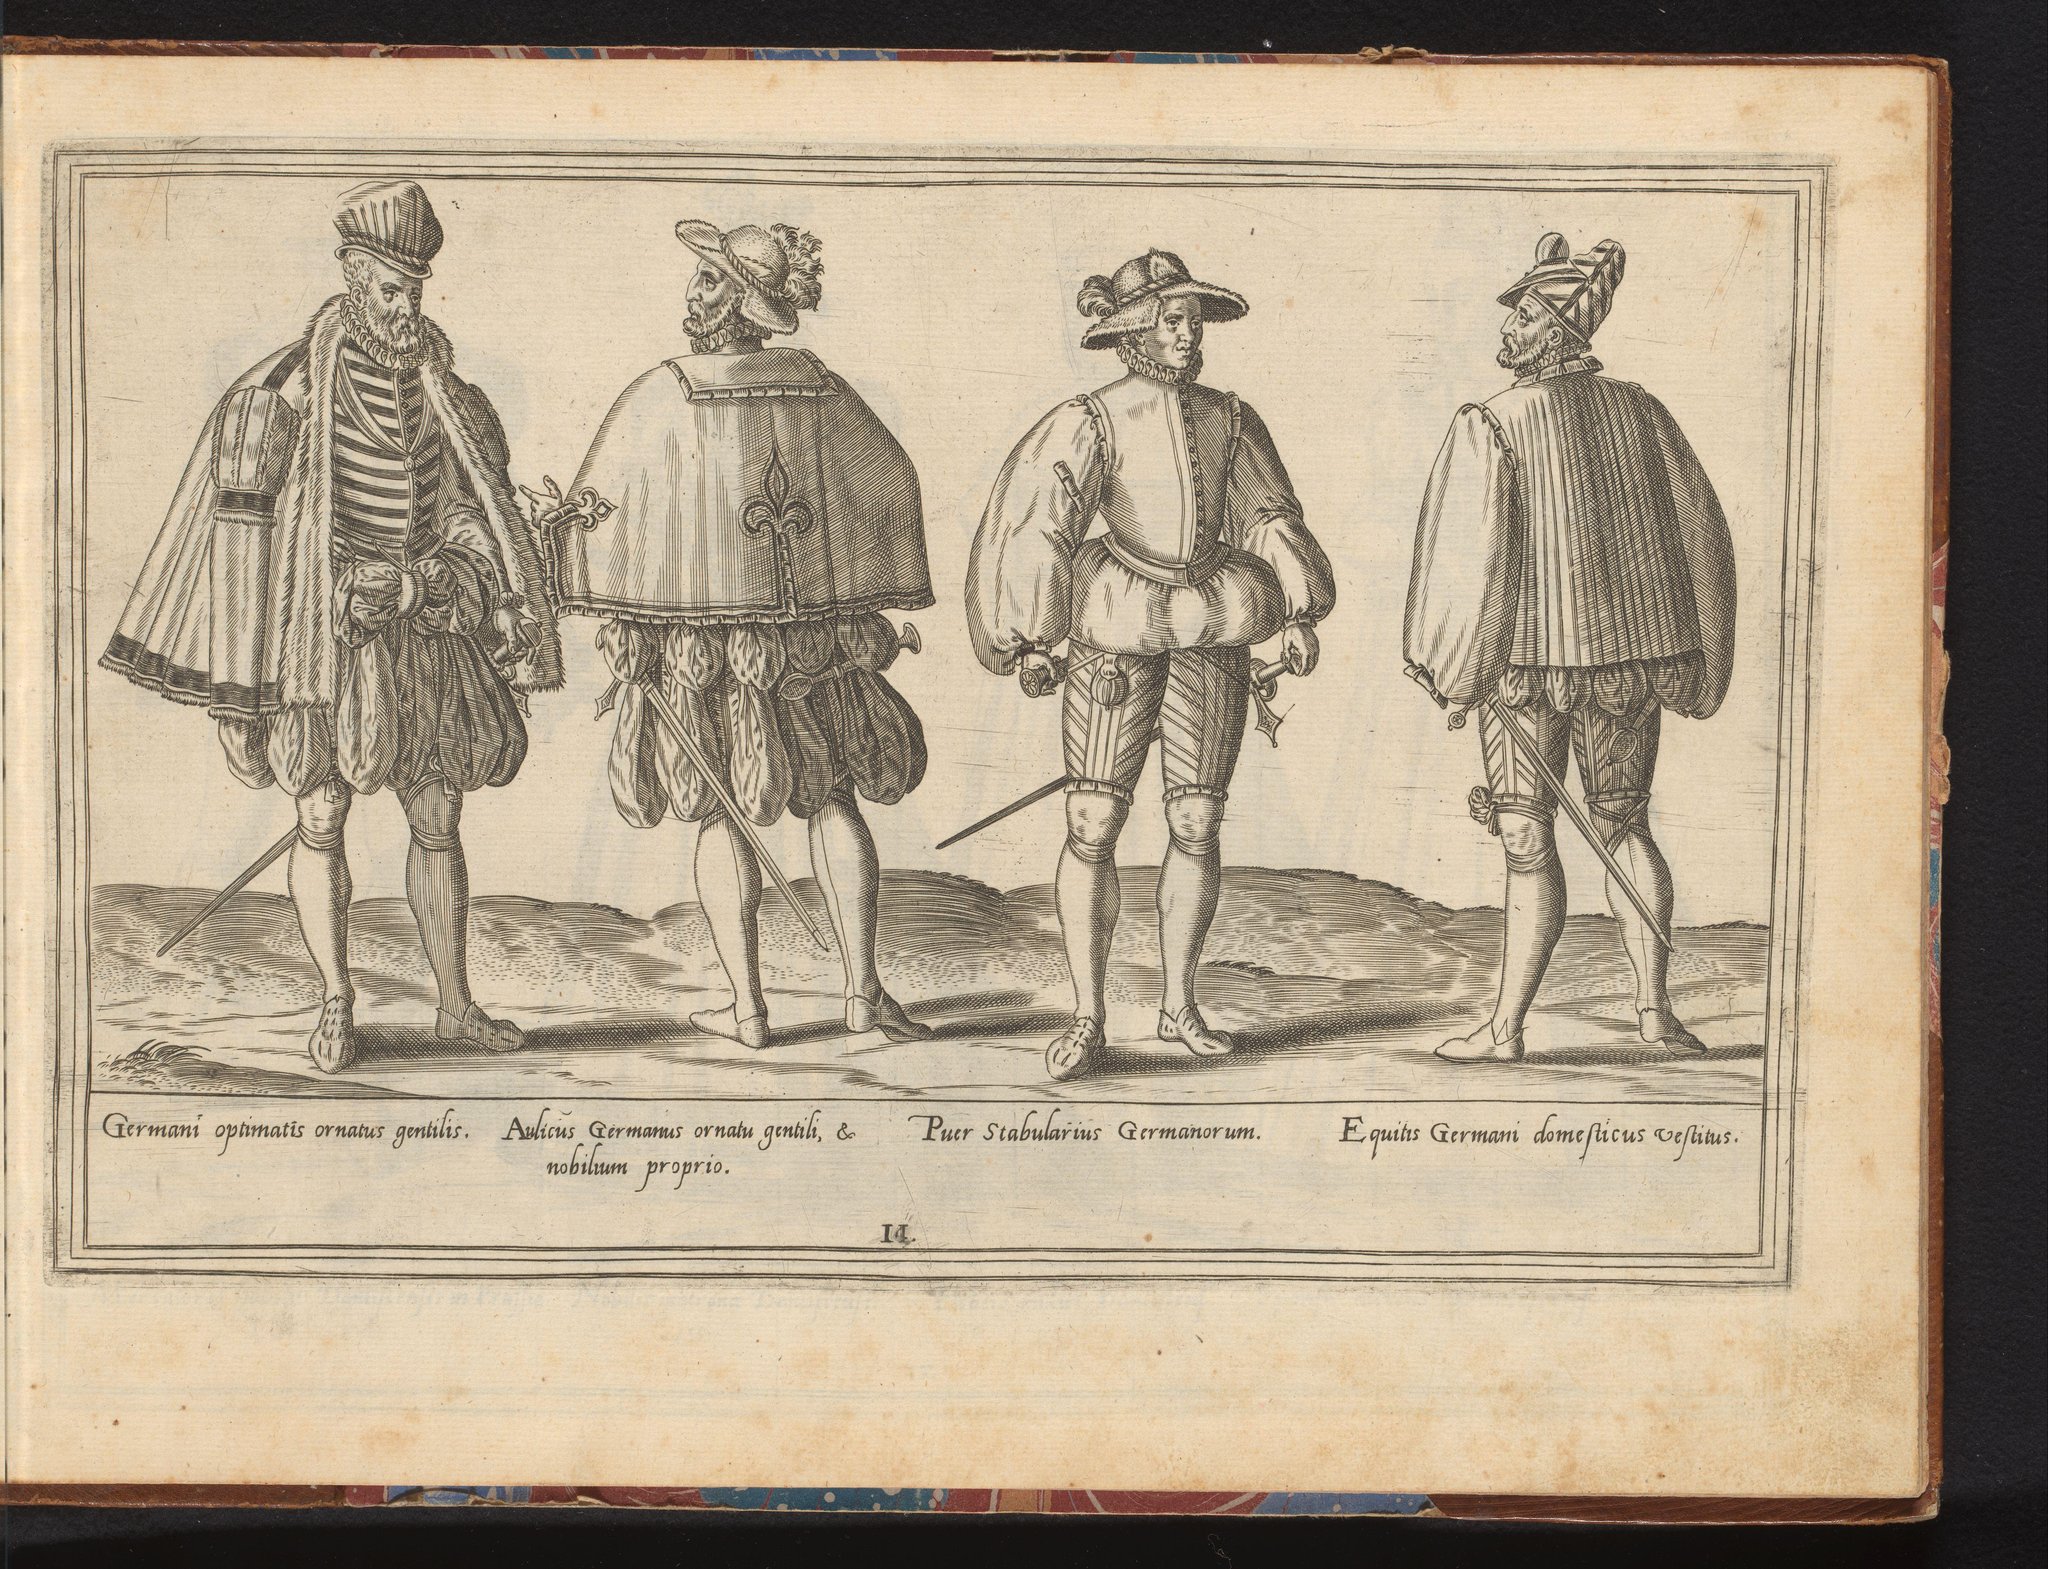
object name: costume print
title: Vier mannen, gekleed volgens de mode in Duitsland, ca. 1580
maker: abraham de bruyn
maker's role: print maker, publisher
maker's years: 1540-1587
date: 1581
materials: paper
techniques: engraving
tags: europeans: germans (+ women), europeans: germans (+ men), europeans: germans (+ costume), clothes, costume (+ men's clothes)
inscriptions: number: ‘11’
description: Links twee vrouwen uit Silezië; rechts een man en een vrouw uit Bohemen. Prent uit het boek 'Omnium pene Europae, Asiae, Aphricae atque Americae gentium habitus...', 1581. De prent maakt deel uit van een album.